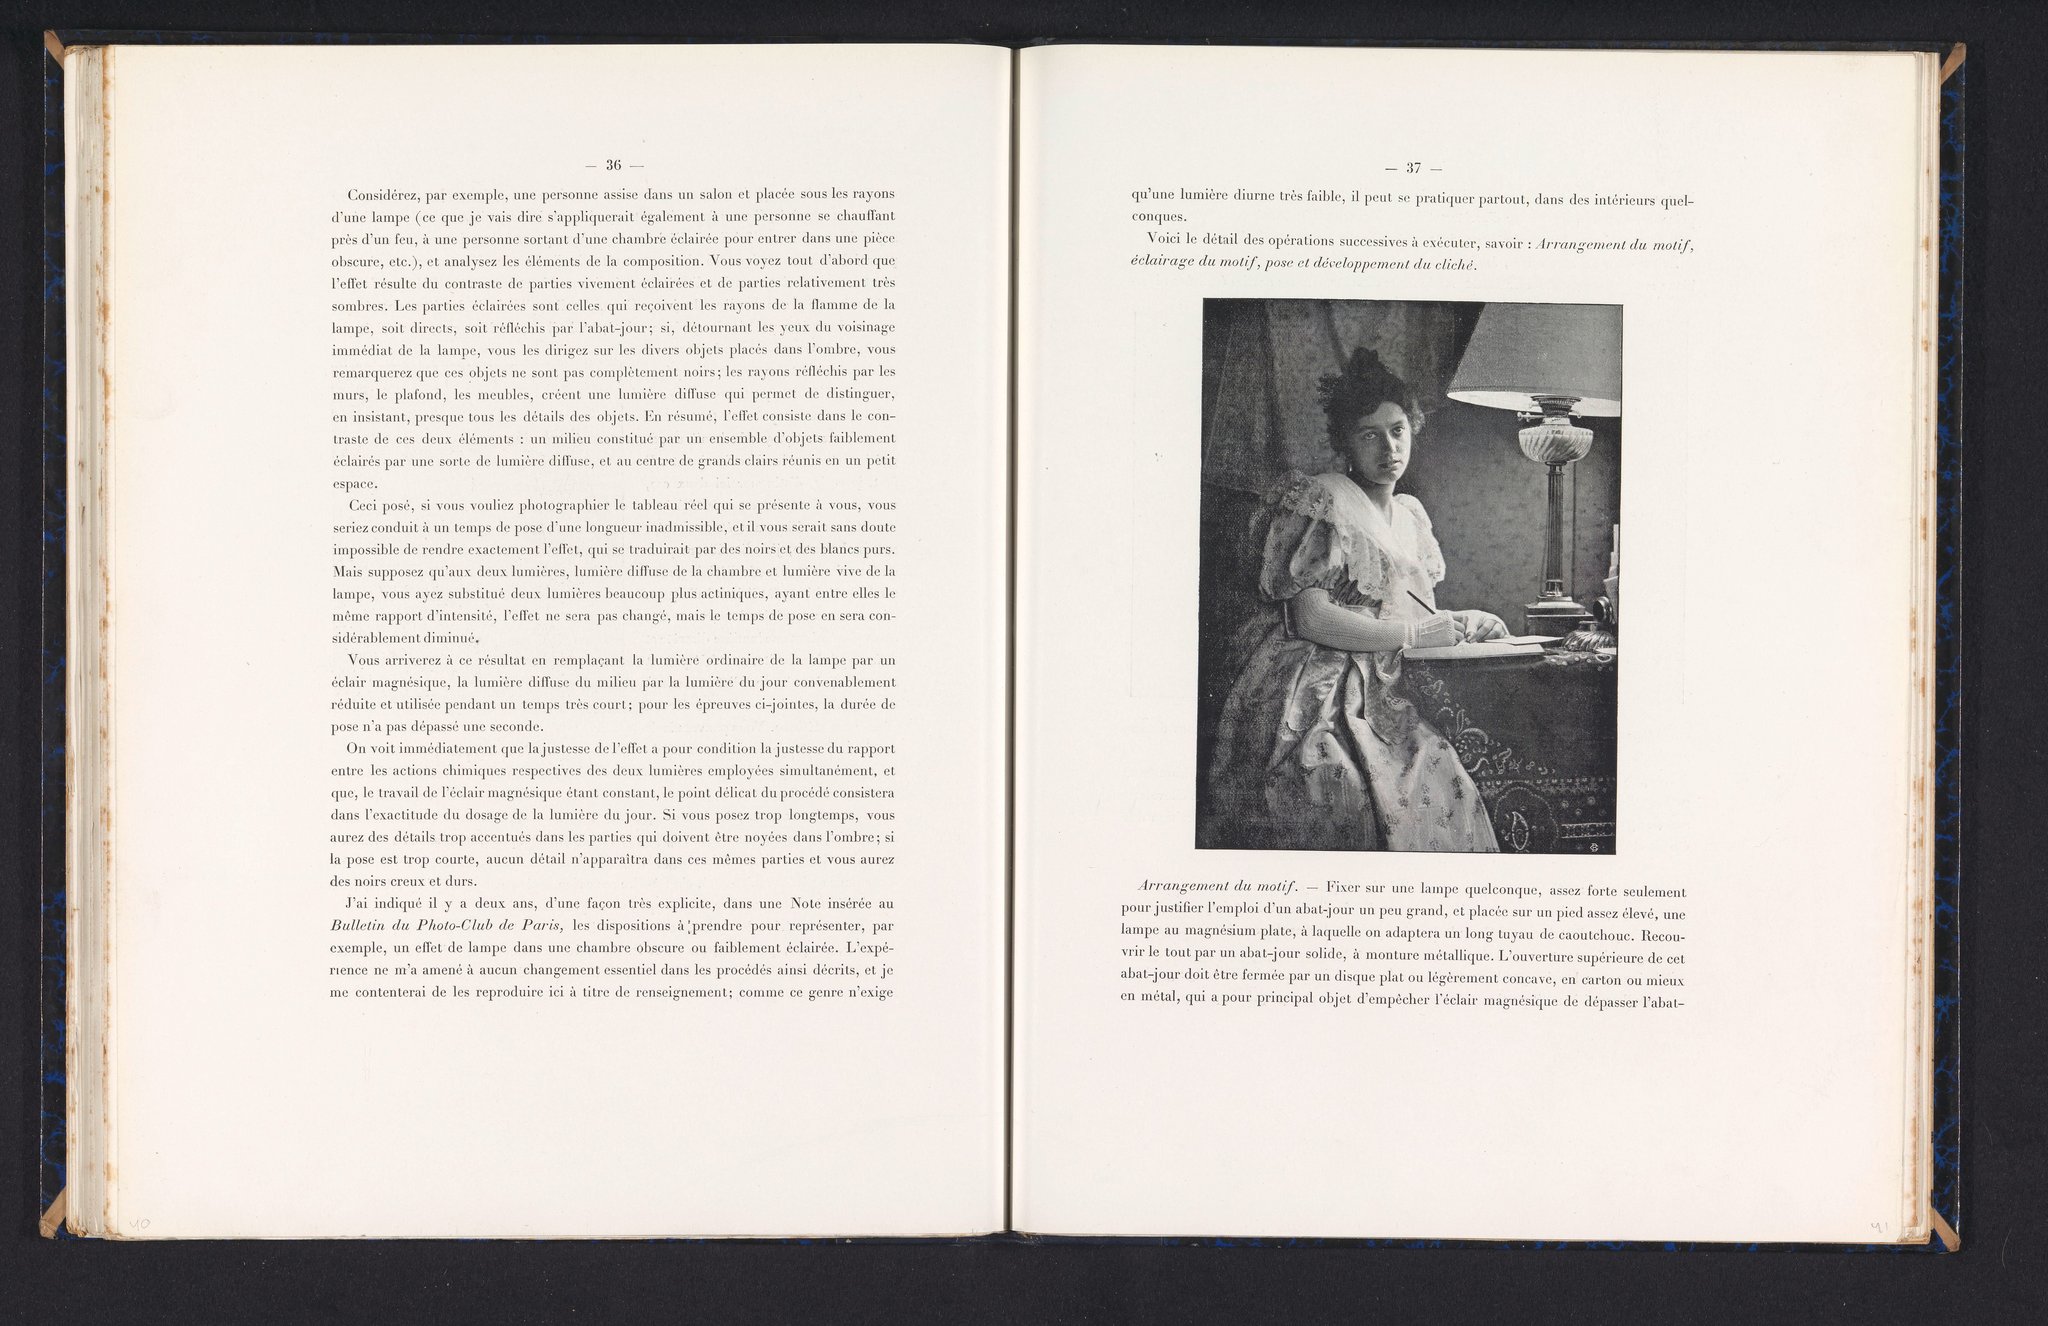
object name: page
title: Schrijvende vrouw aan een tafel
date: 1886-1896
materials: paper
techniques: autotype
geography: france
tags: handwriting, writing as activity, adult woman, table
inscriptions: inscription: ‘CB’